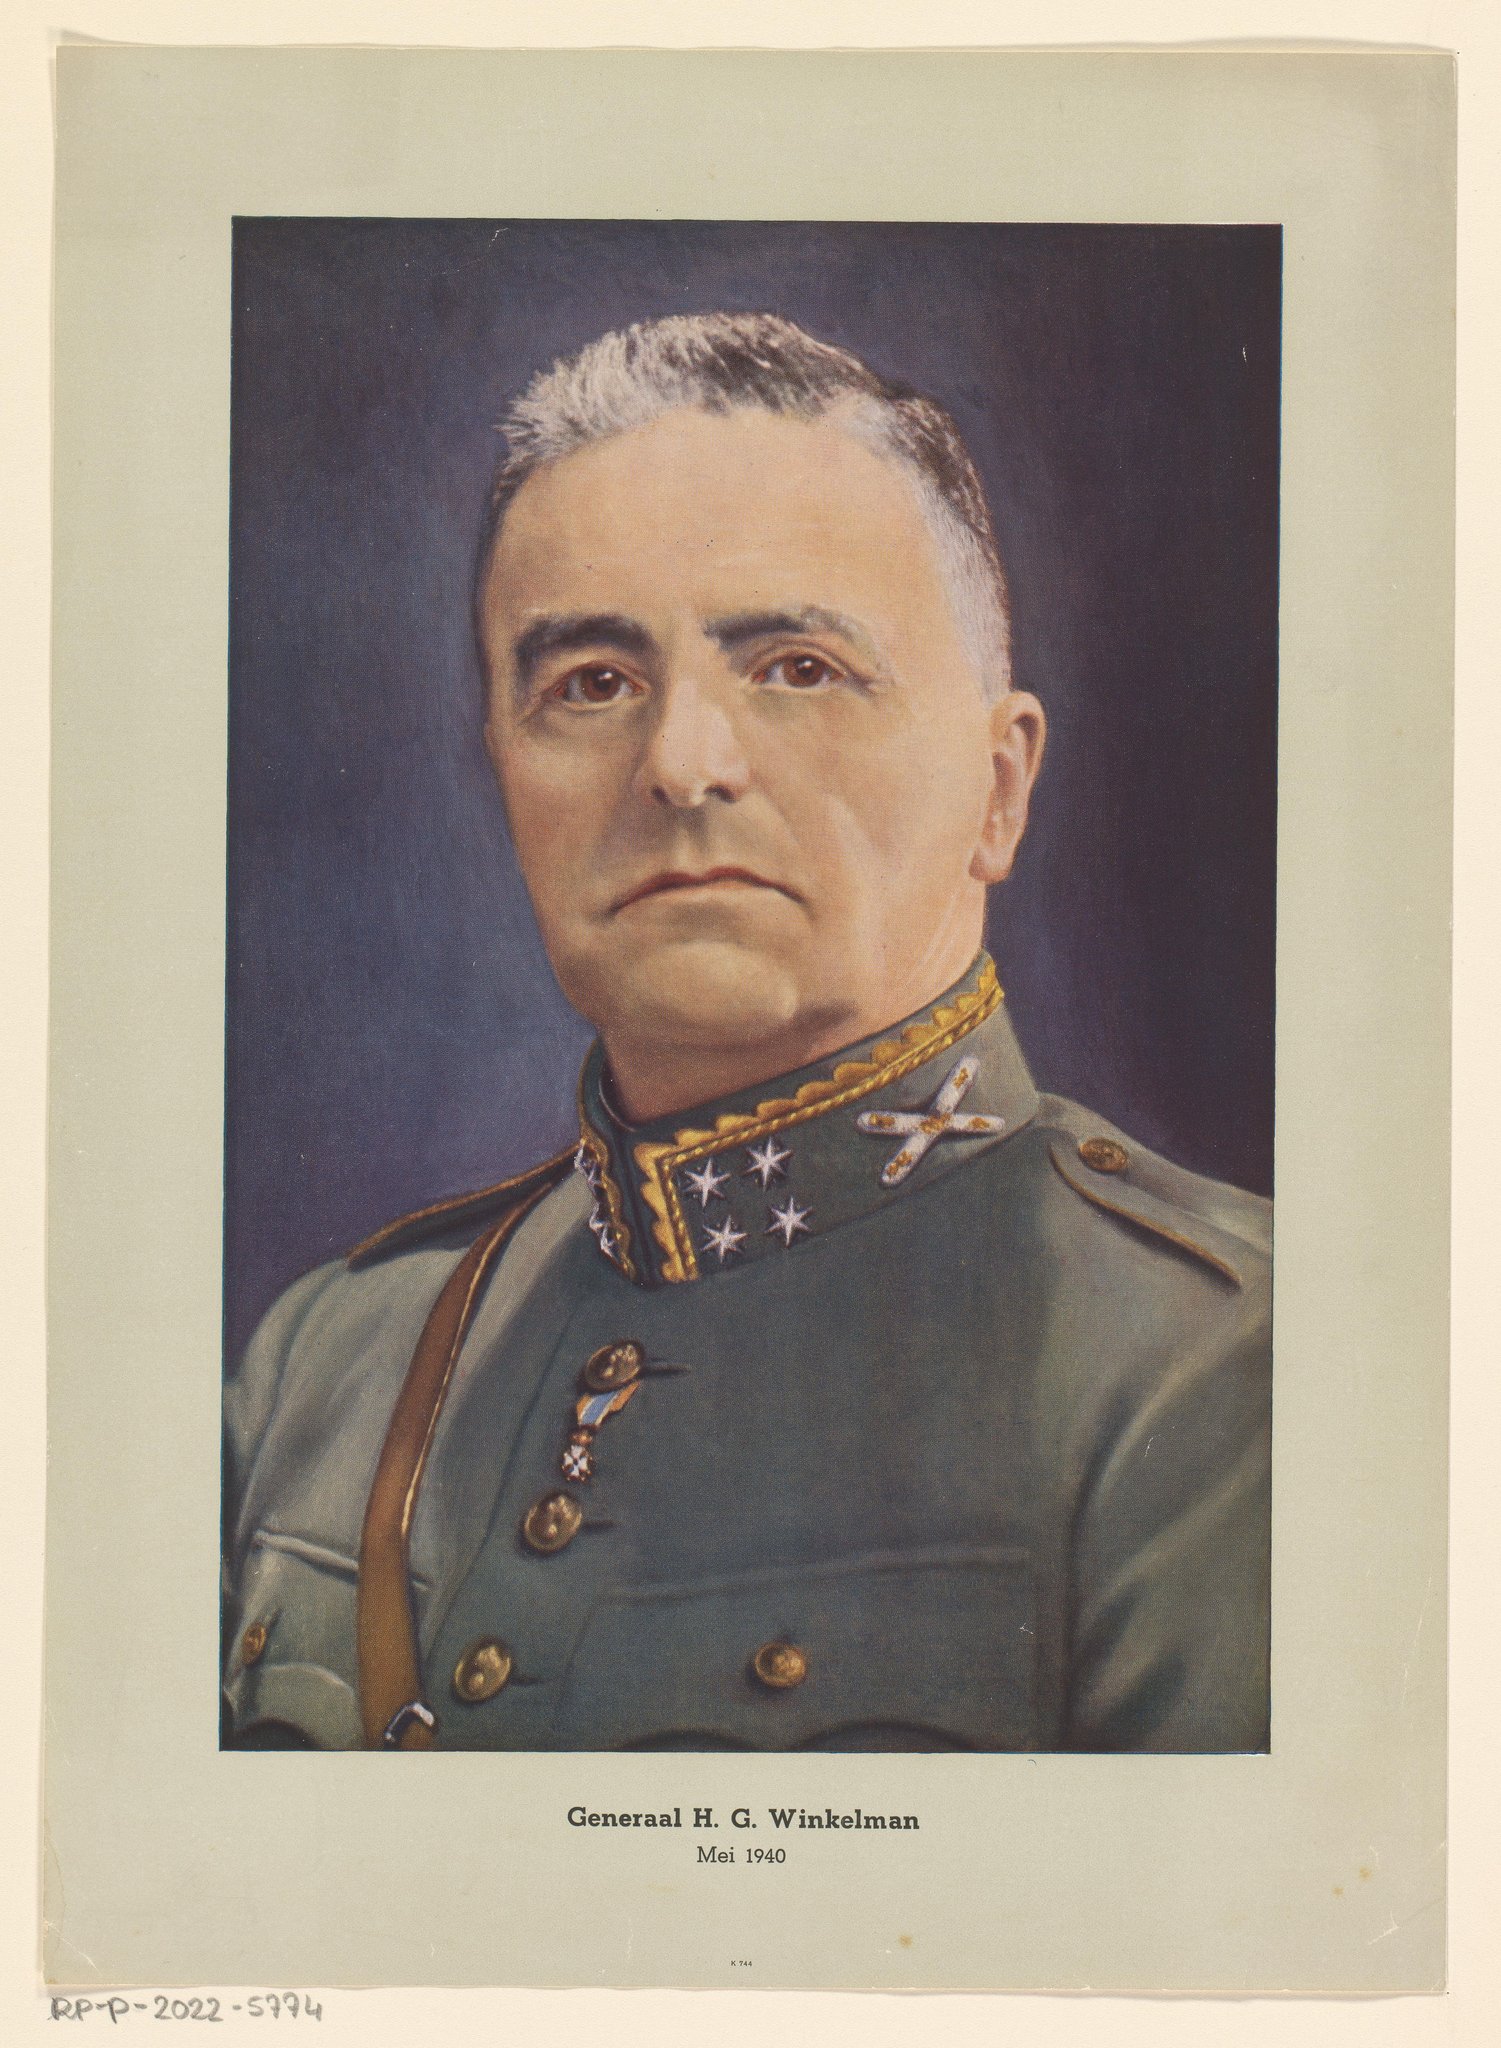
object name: photomechanical print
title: Portret van Henri Gerard Winkelman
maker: Anonymous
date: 1940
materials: paper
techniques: four-color autotype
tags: maastricht, historical persons, officer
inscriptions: collector's mark: Lugt 2228